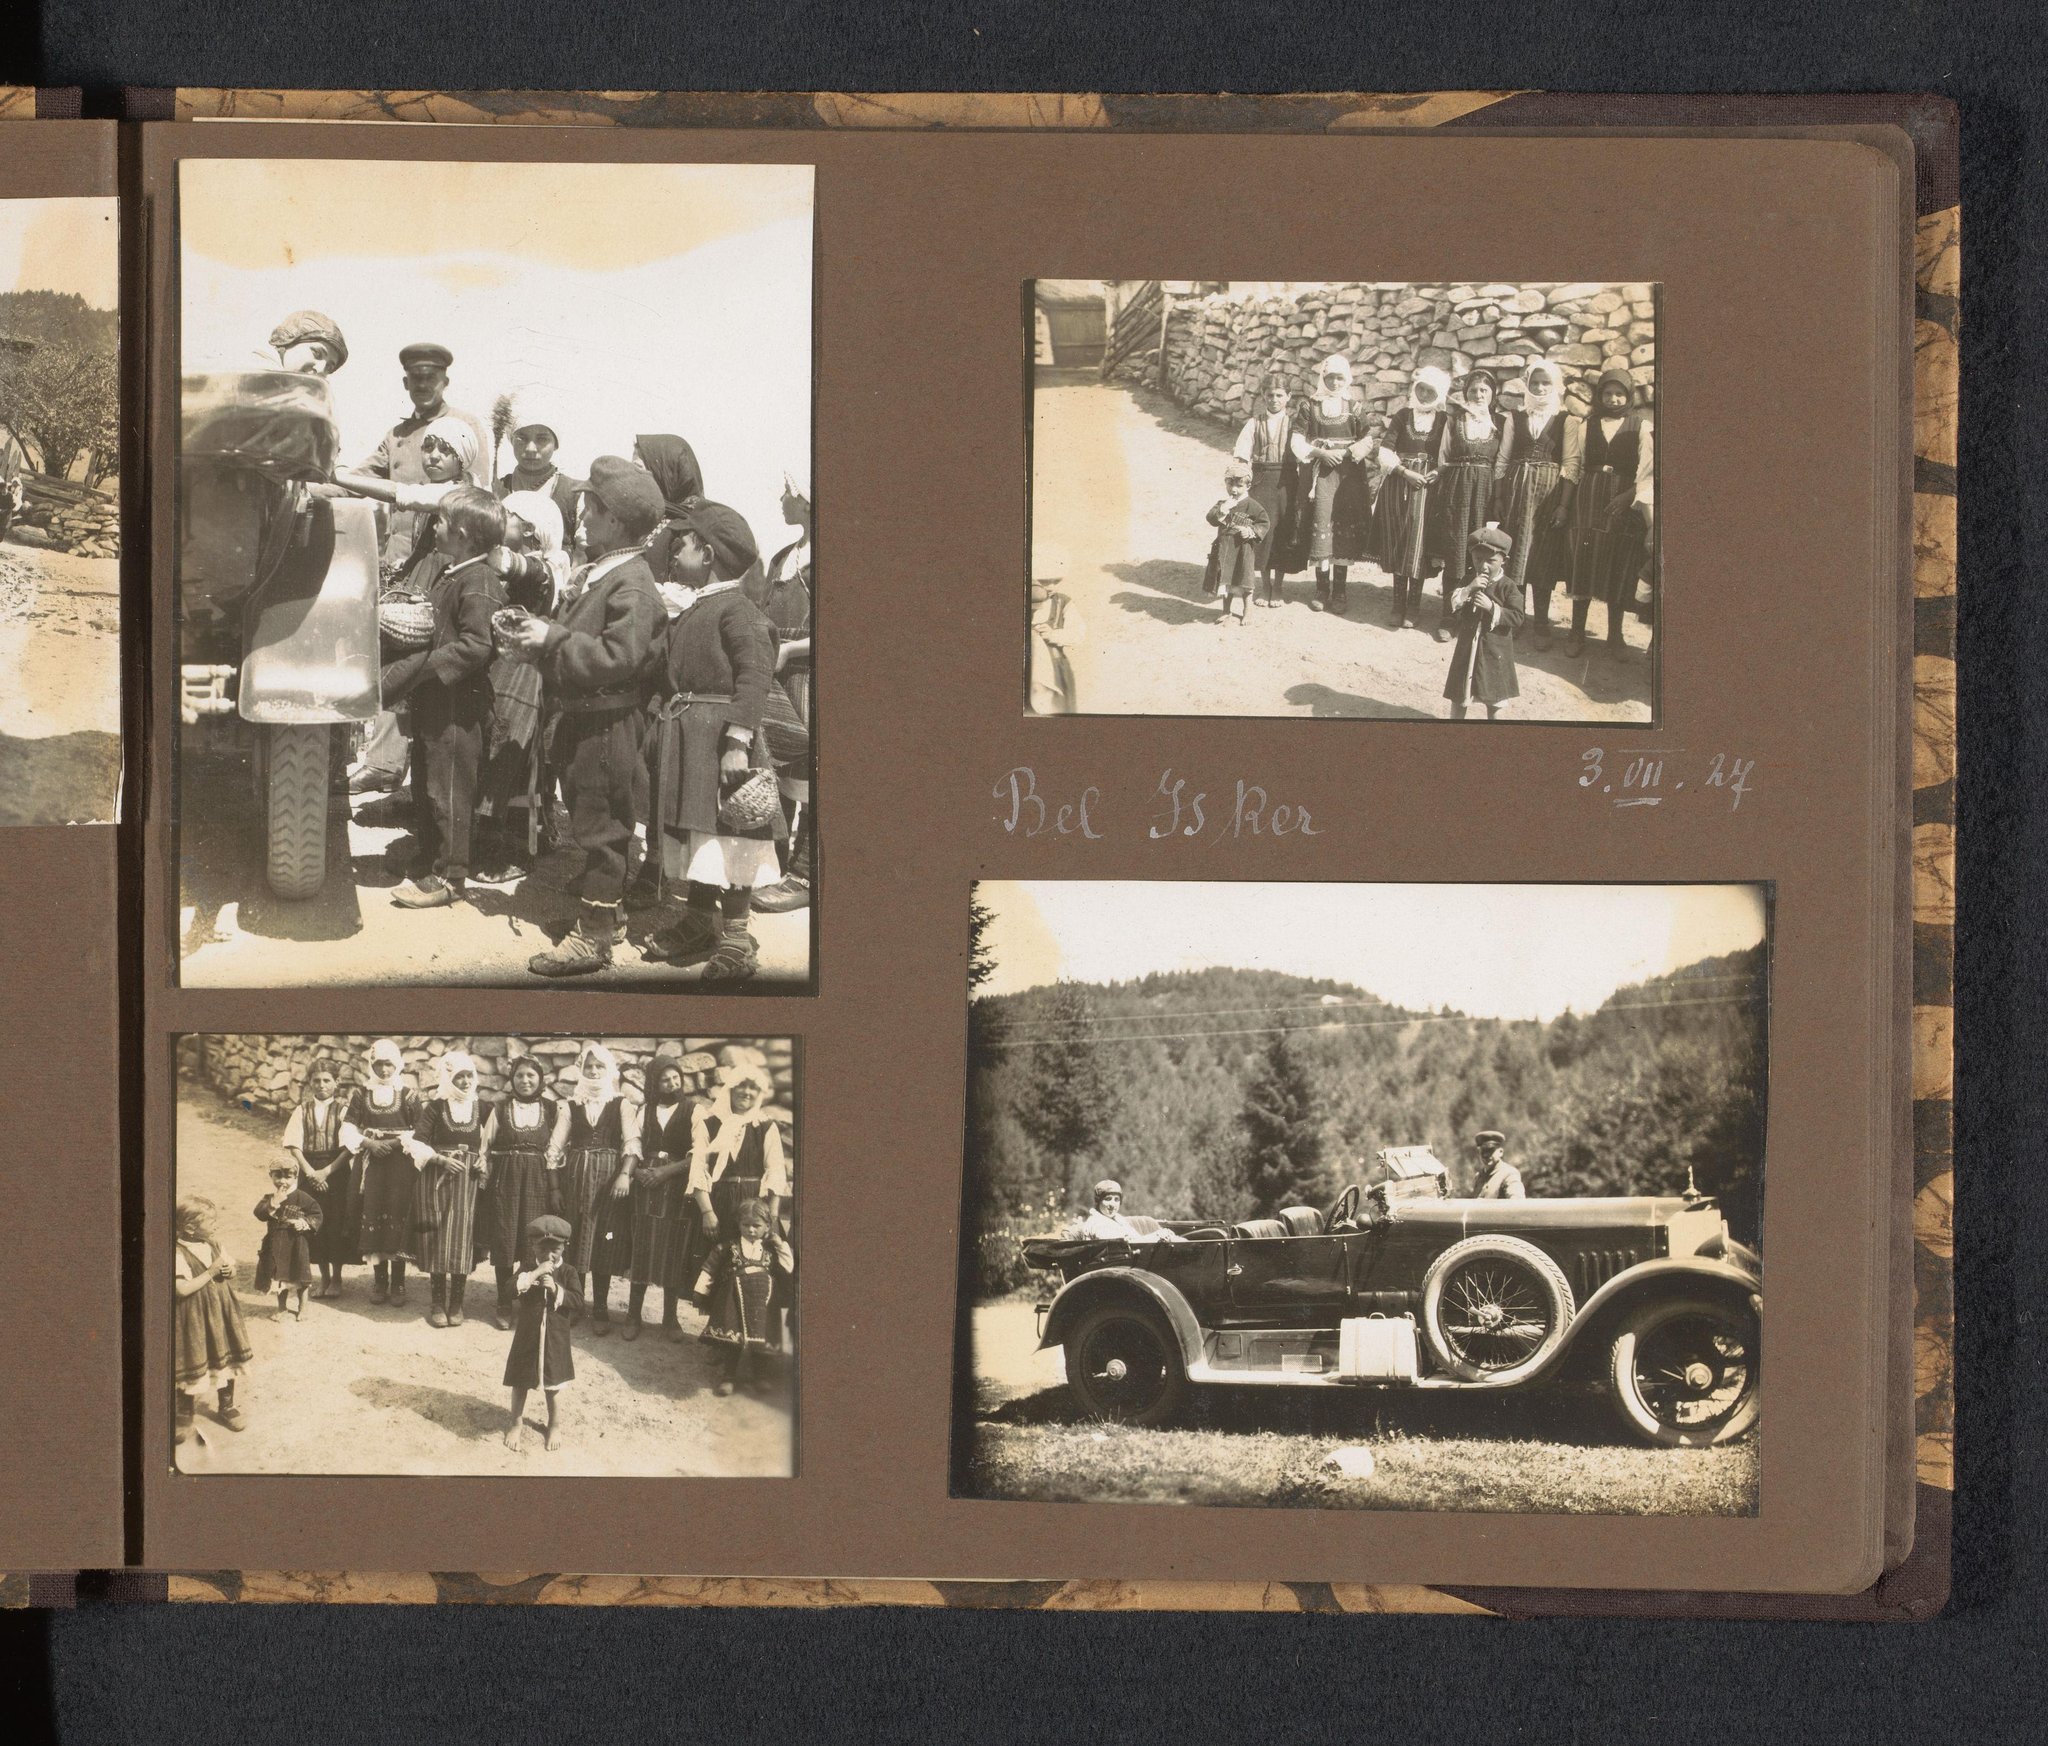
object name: album leaf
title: Bulgaarse kinderen, gefotografeerd tijdens een rondreis van Else Wachenheimer-Moos en Eugen Wachenheimer door Bulgarije, 1926-1927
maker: else wachenheimer-moos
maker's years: 1895-1944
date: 1926-1927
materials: paper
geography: bulgaria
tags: bulgarije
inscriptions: inscription: ‘Erdbeerkinder (onleesbaar)’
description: Albumblad bevat vier foto's van onbekende kinderen. Afkomstig uit album half formaat, kartonomslag met koordbinding en lichte veelvormige vormen op voorzijde.